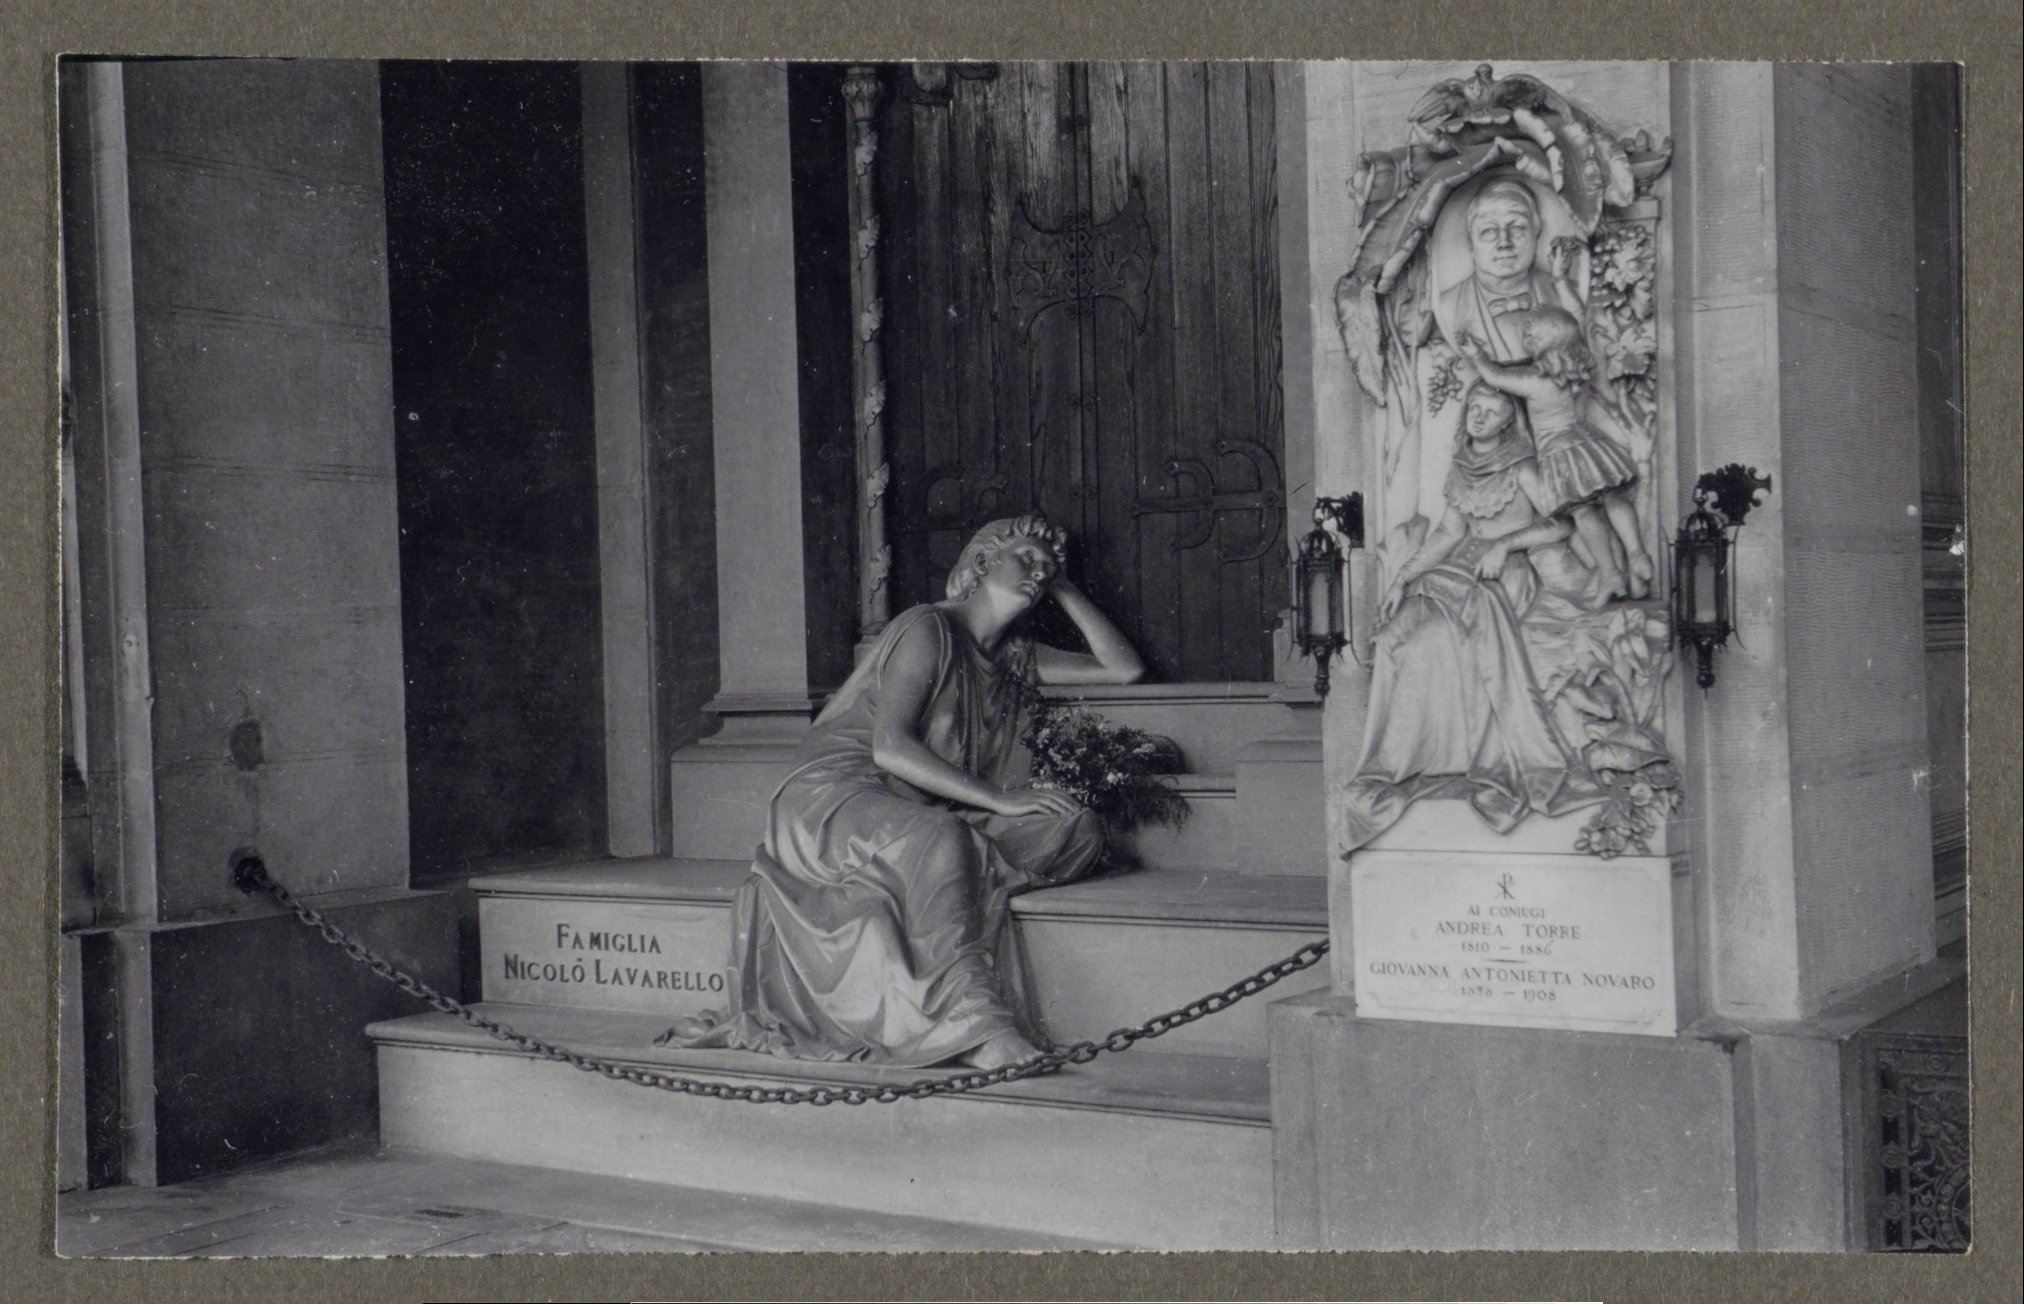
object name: photograph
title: Graftombe van de familie Nicolò Lavarello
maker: Anonymous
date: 1920-1930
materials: photographic support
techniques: gelatin silver print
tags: grave, tomb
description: Achter een ketting een werk van beeldhouwer Santo Saccomanno (1833 -1914), voorstellend een rouwende vrouw, zittend op de trappen naar een toegangsdeur. Rechts een beeld in reliëf van een zittende vrouw, een man en een kind. Daaronder een grafbord met daarin de namen van Andrea Torre en Giovanna Antonietta Novaro uitgehouwen. De graftombe bevindt zich op een begraafplaats in Genua. Onderdeel van familiealbum Nederlands-Indië.